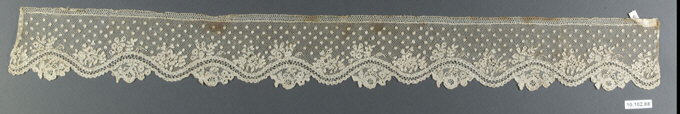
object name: fragment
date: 1801-1900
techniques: lace